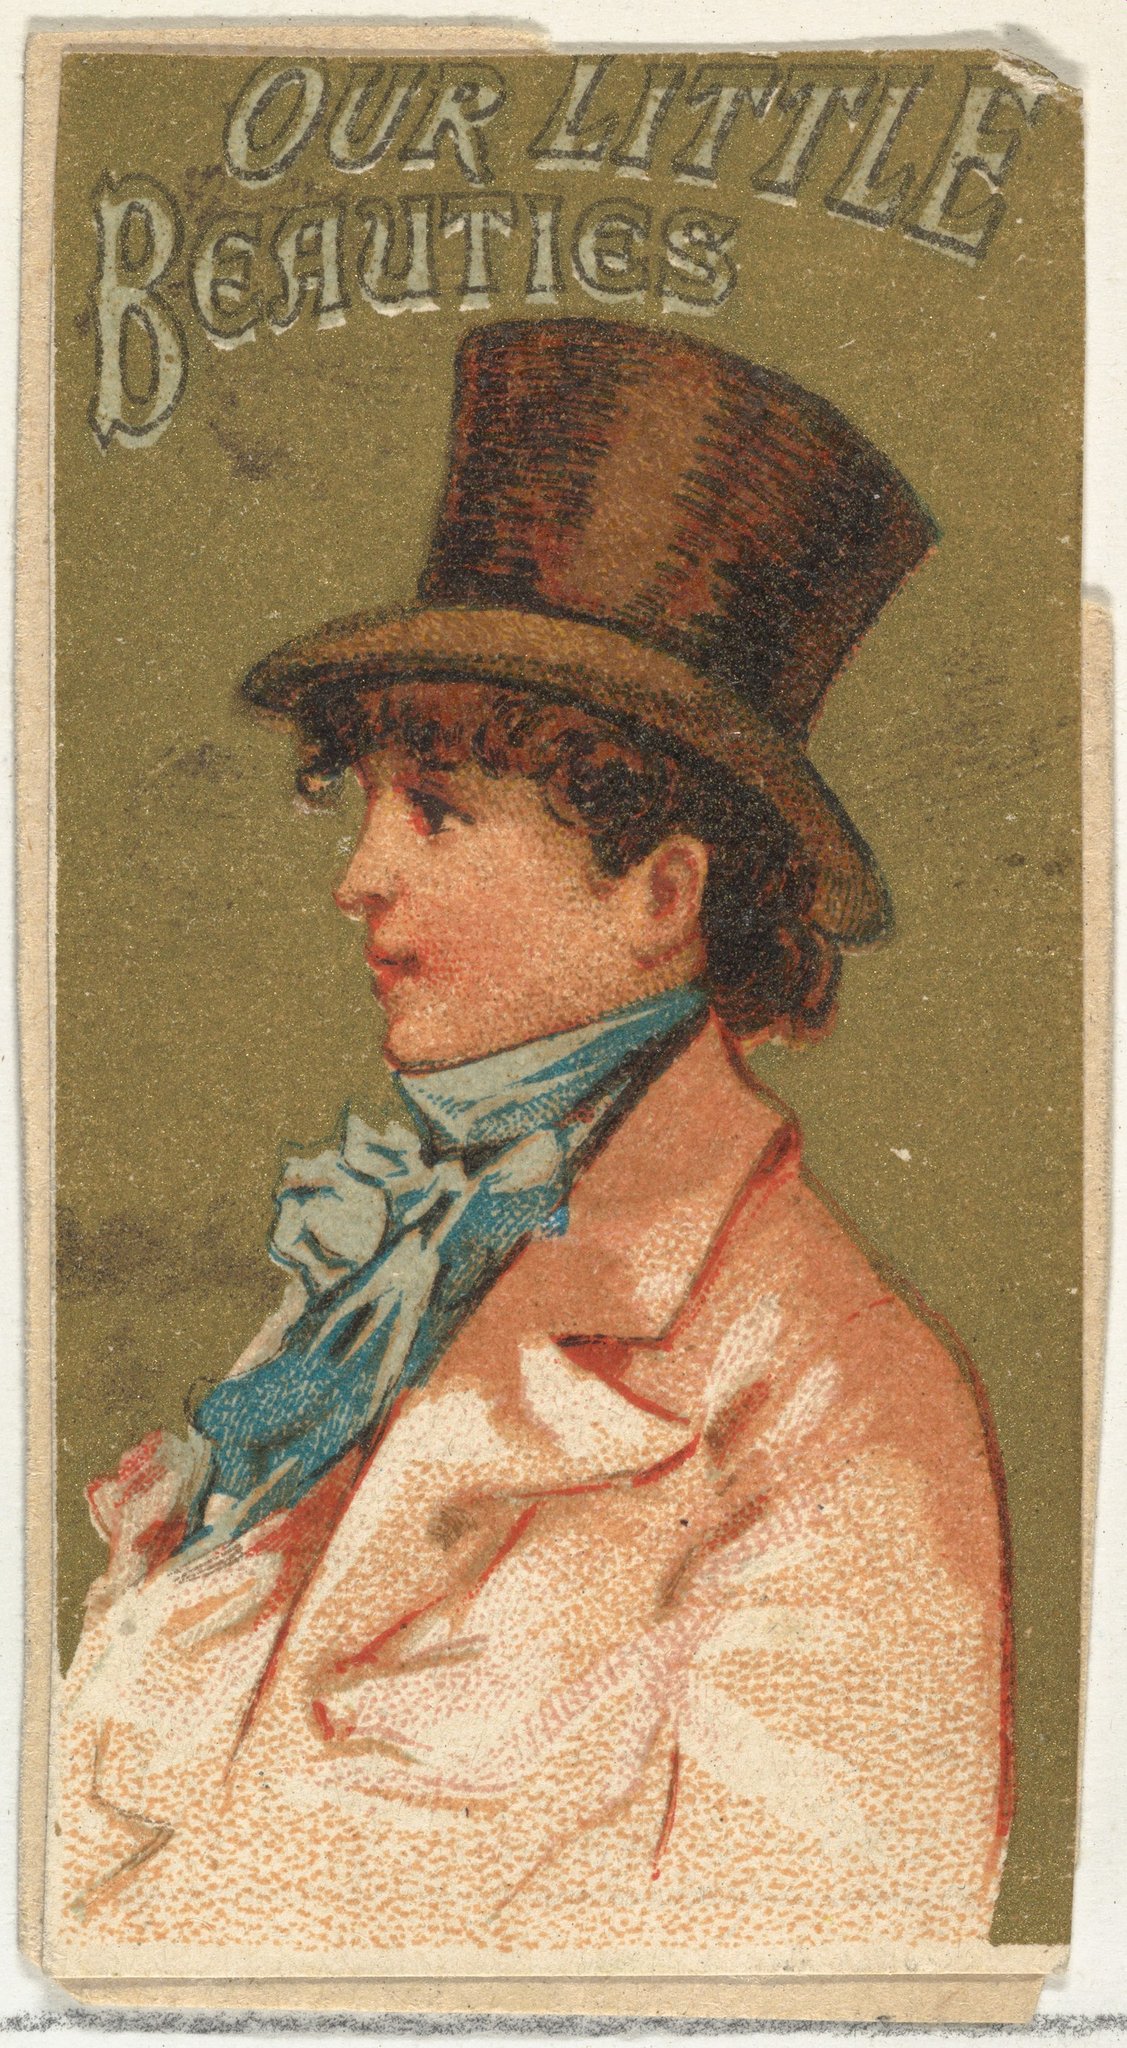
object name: print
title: From the Girls and Children series (N58) promoting Our Little Beauties Cigarettes for Allen & Ginter brand tobacco products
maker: allen & ginter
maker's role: publisher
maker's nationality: american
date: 1887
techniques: color lithograph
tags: girls